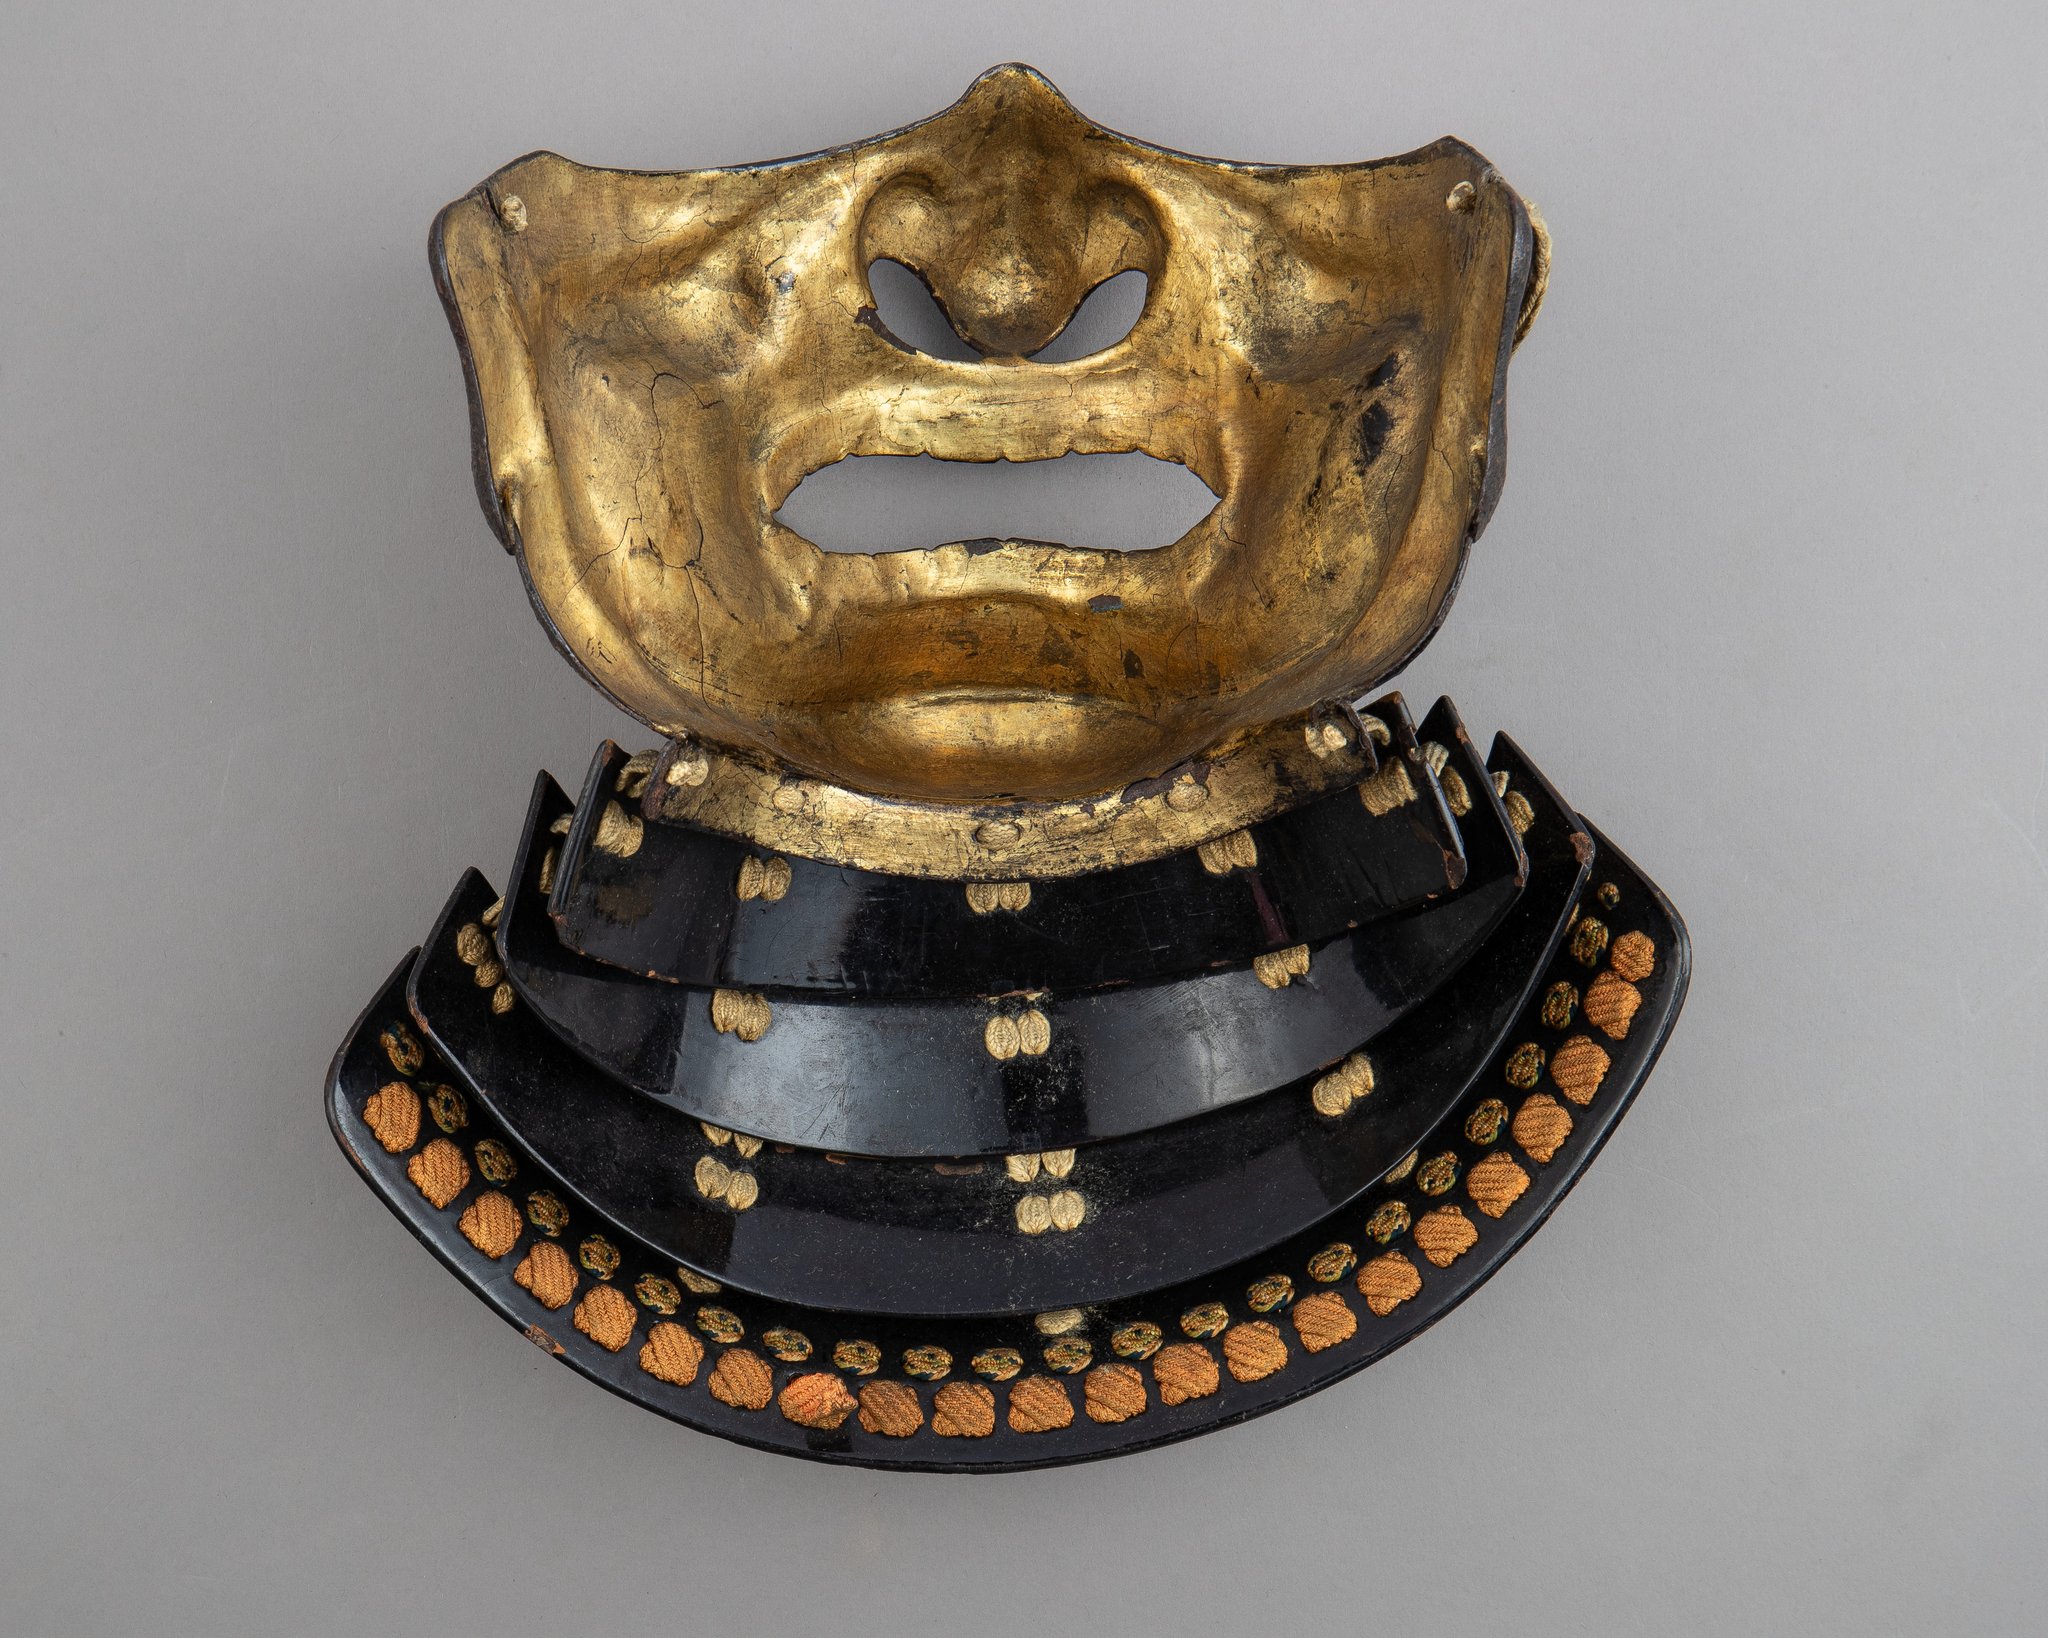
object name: half mask menpō with gorget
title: Half Mask (Menpō) with Gorget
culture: japanese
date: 1615-1868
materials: iron, lacquer, textile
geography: japan